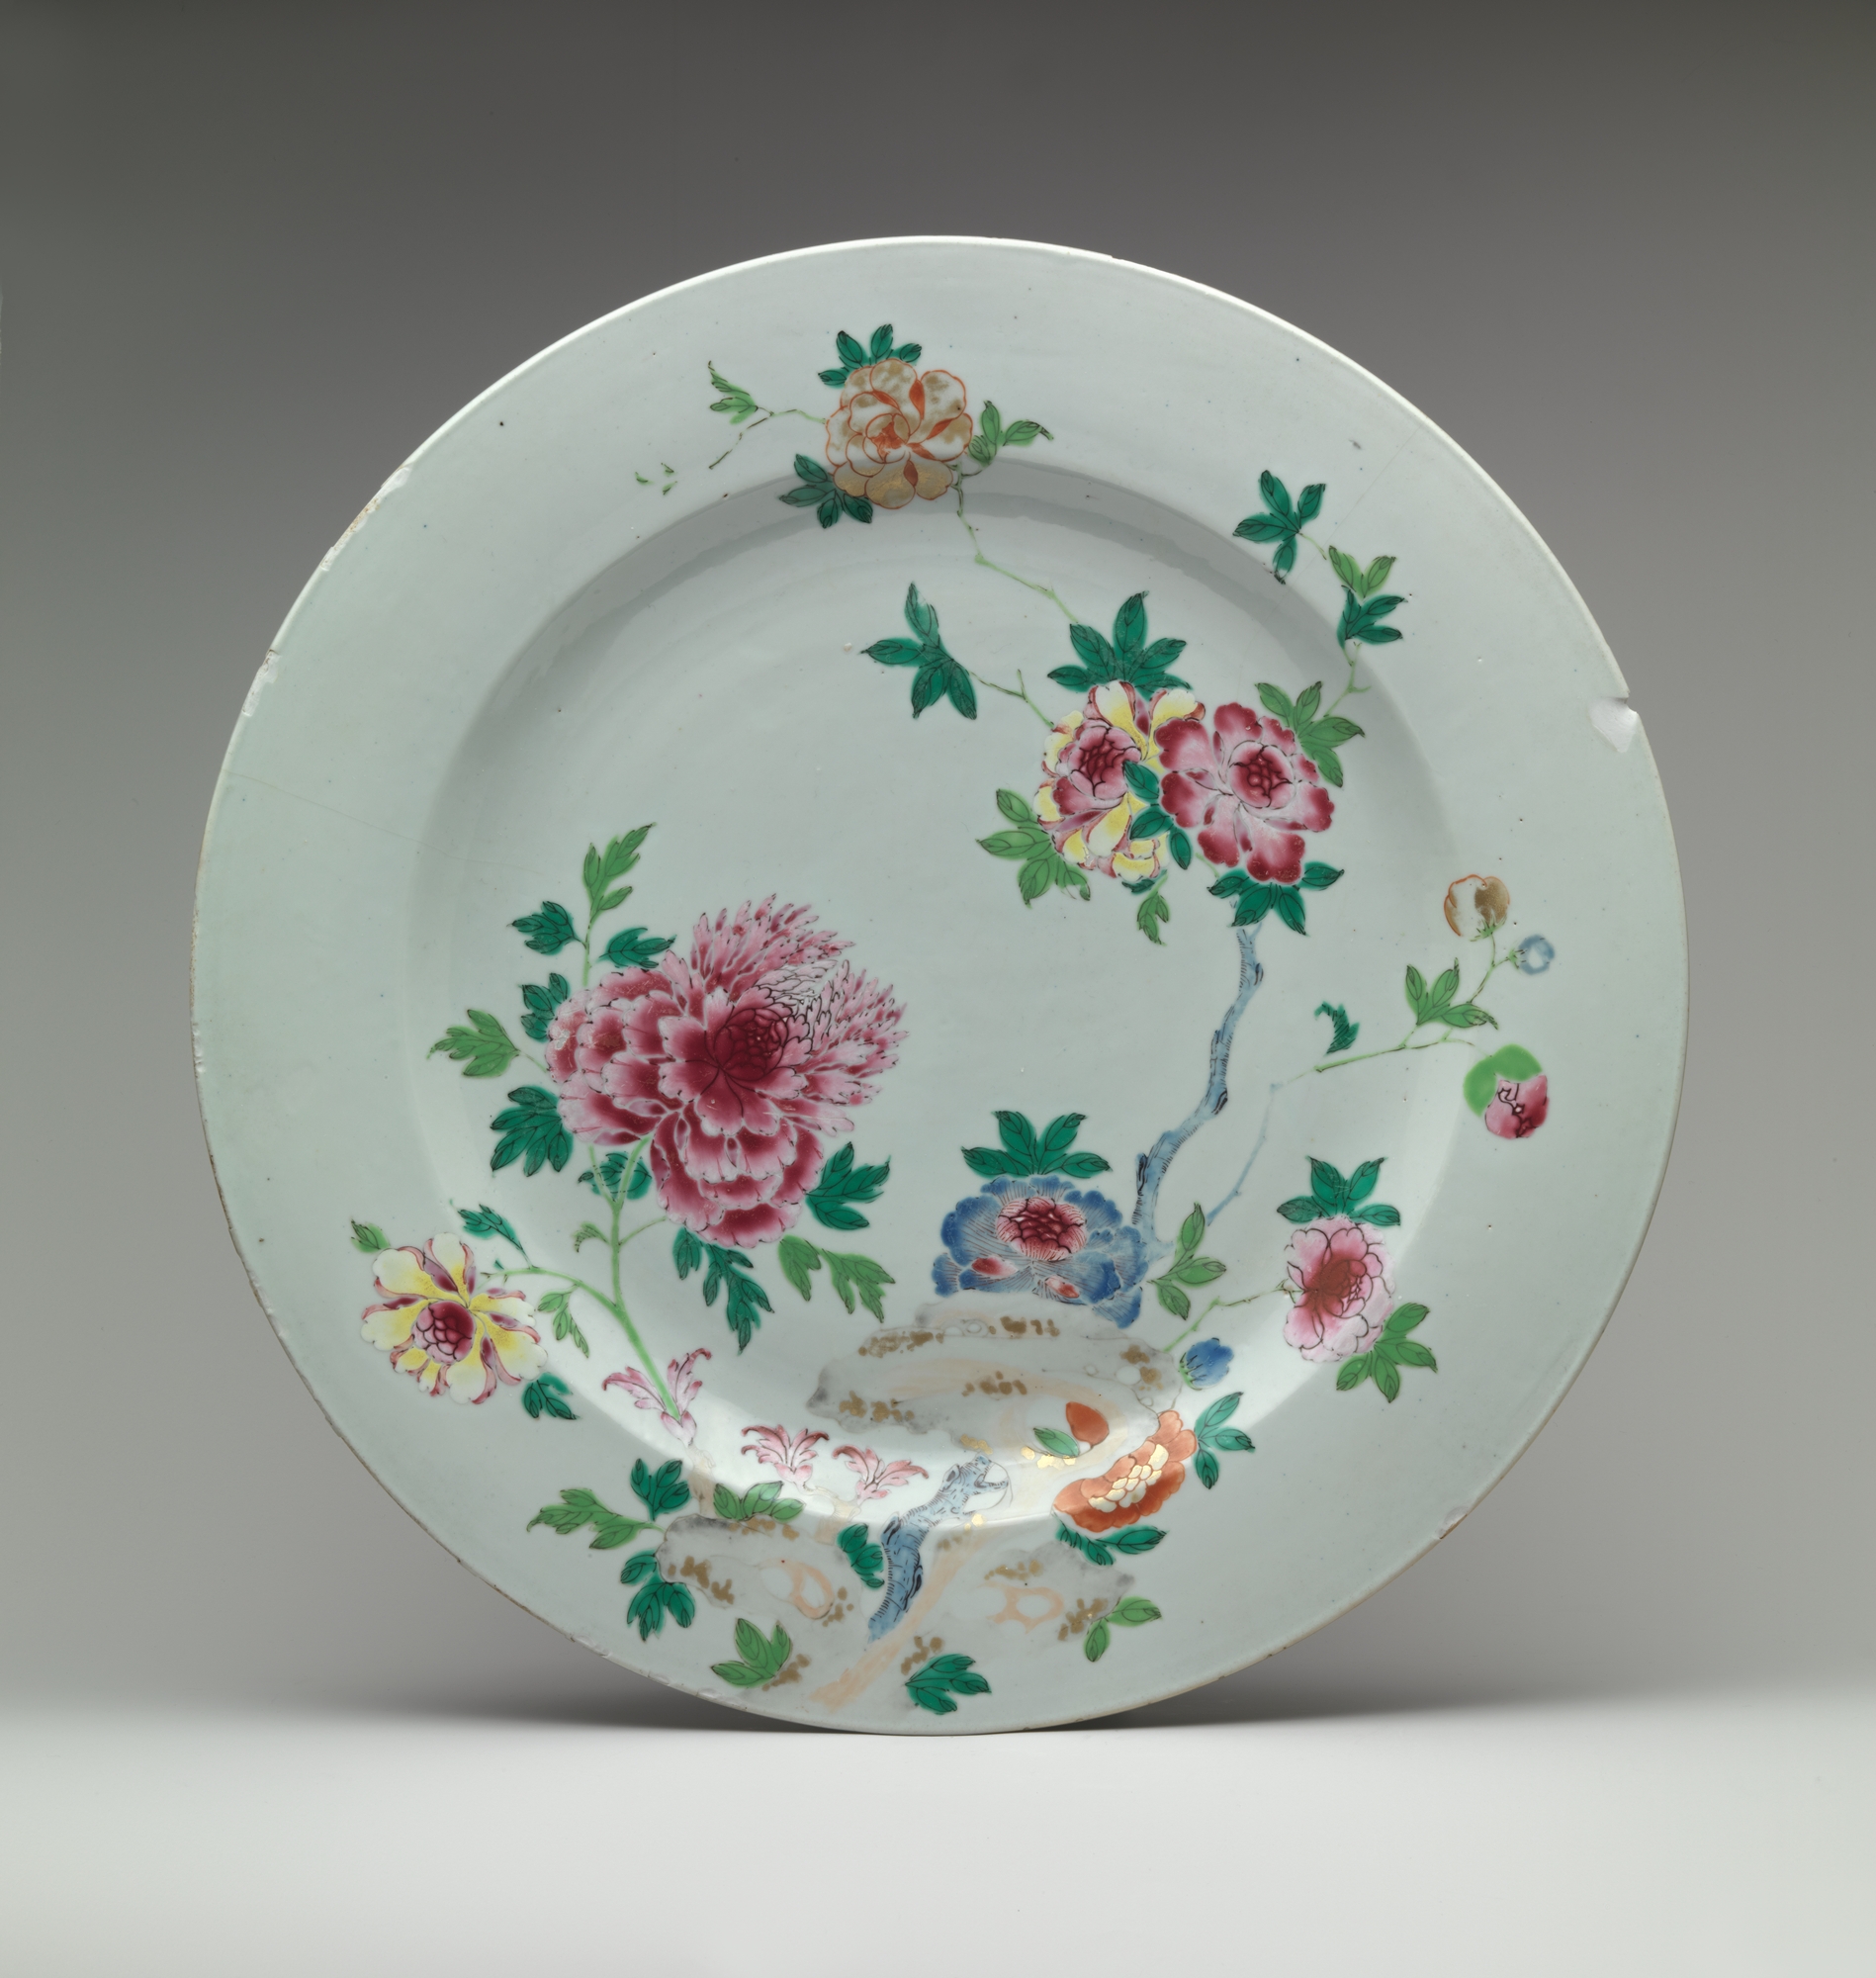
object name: plate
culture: chinese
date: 1730-1770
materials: porcelain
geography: china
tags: flowers